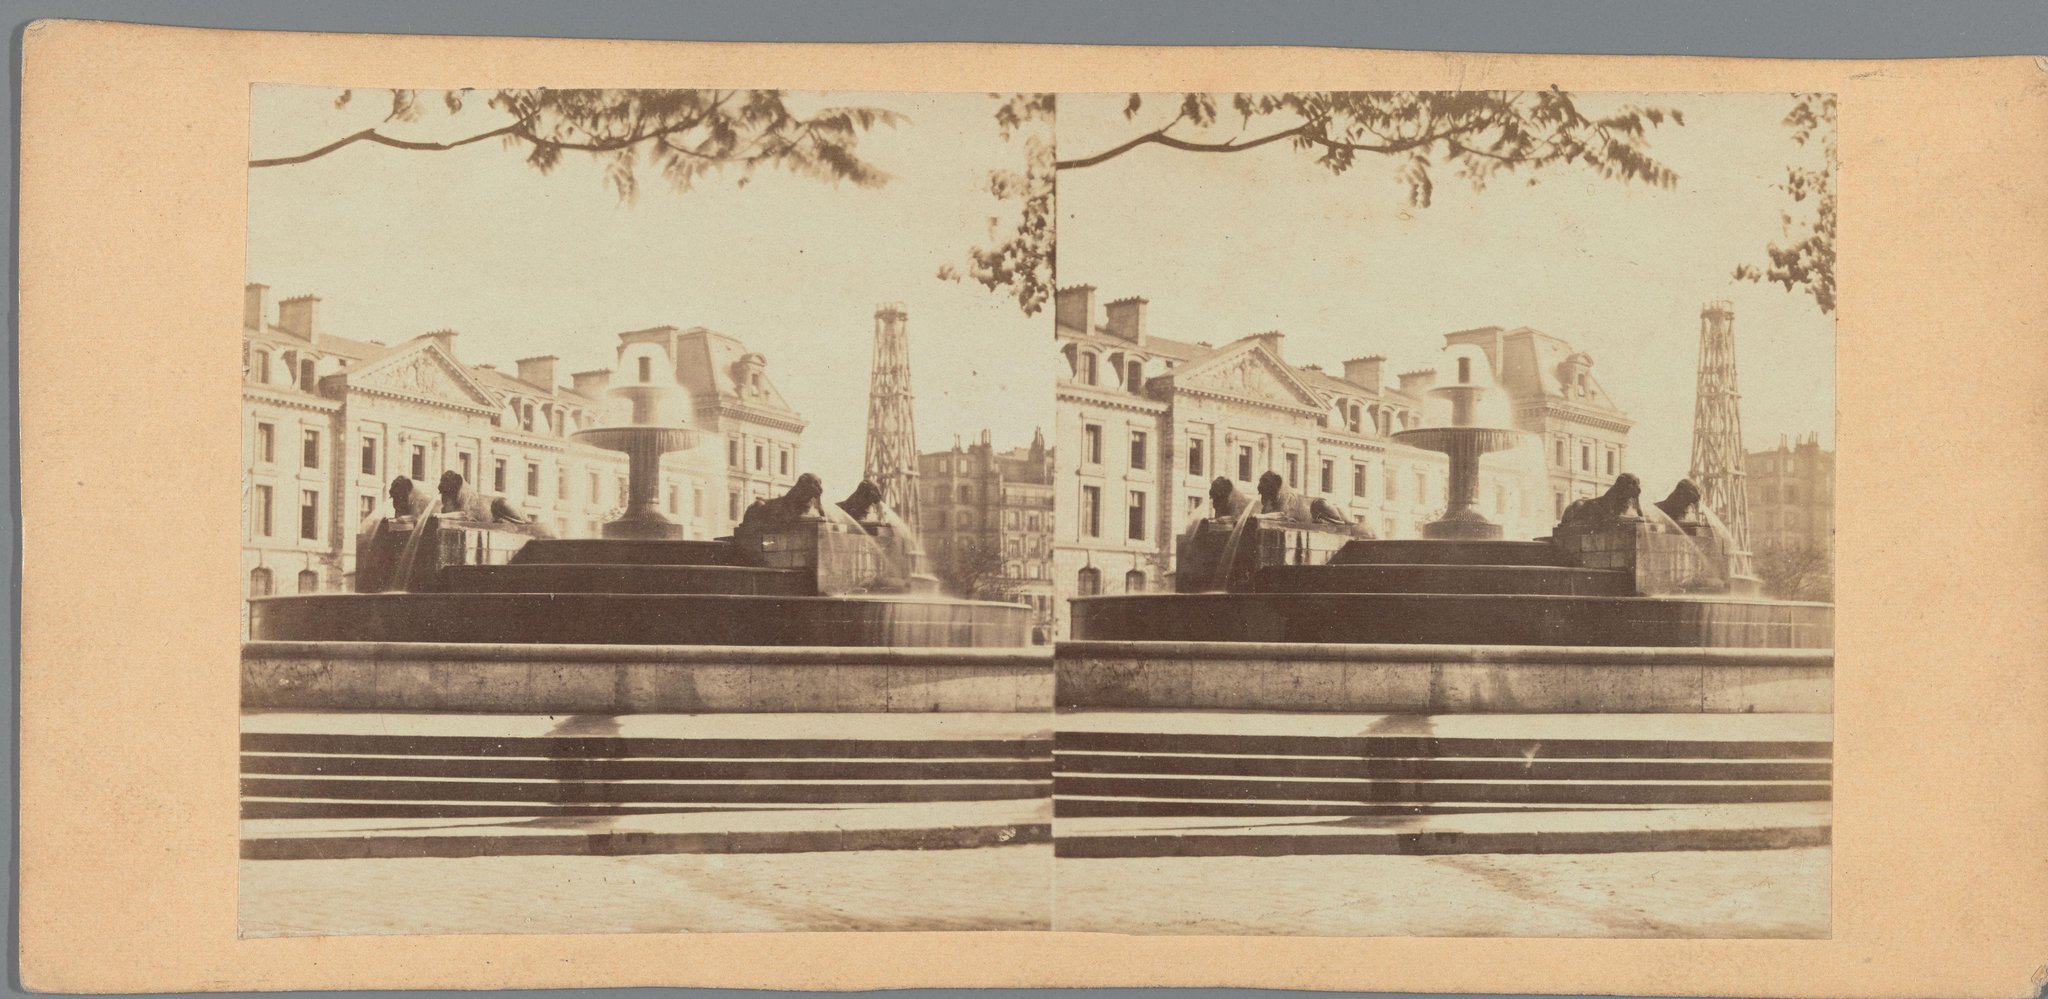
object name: stereograph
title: Fontein van Château d'eau in Parijs op de (huidige) Place de la République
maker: Anonymous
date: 1860-1880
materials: cardboard, paper, photographic support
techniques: albumen print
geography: paris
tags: piece of sculpture, reproduction of a piece of sculpture (+ sculpture), ornamental fountain (+ city(-scape) with figures, staffage), paris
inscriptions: inscription: ‘Chateau d'eau’